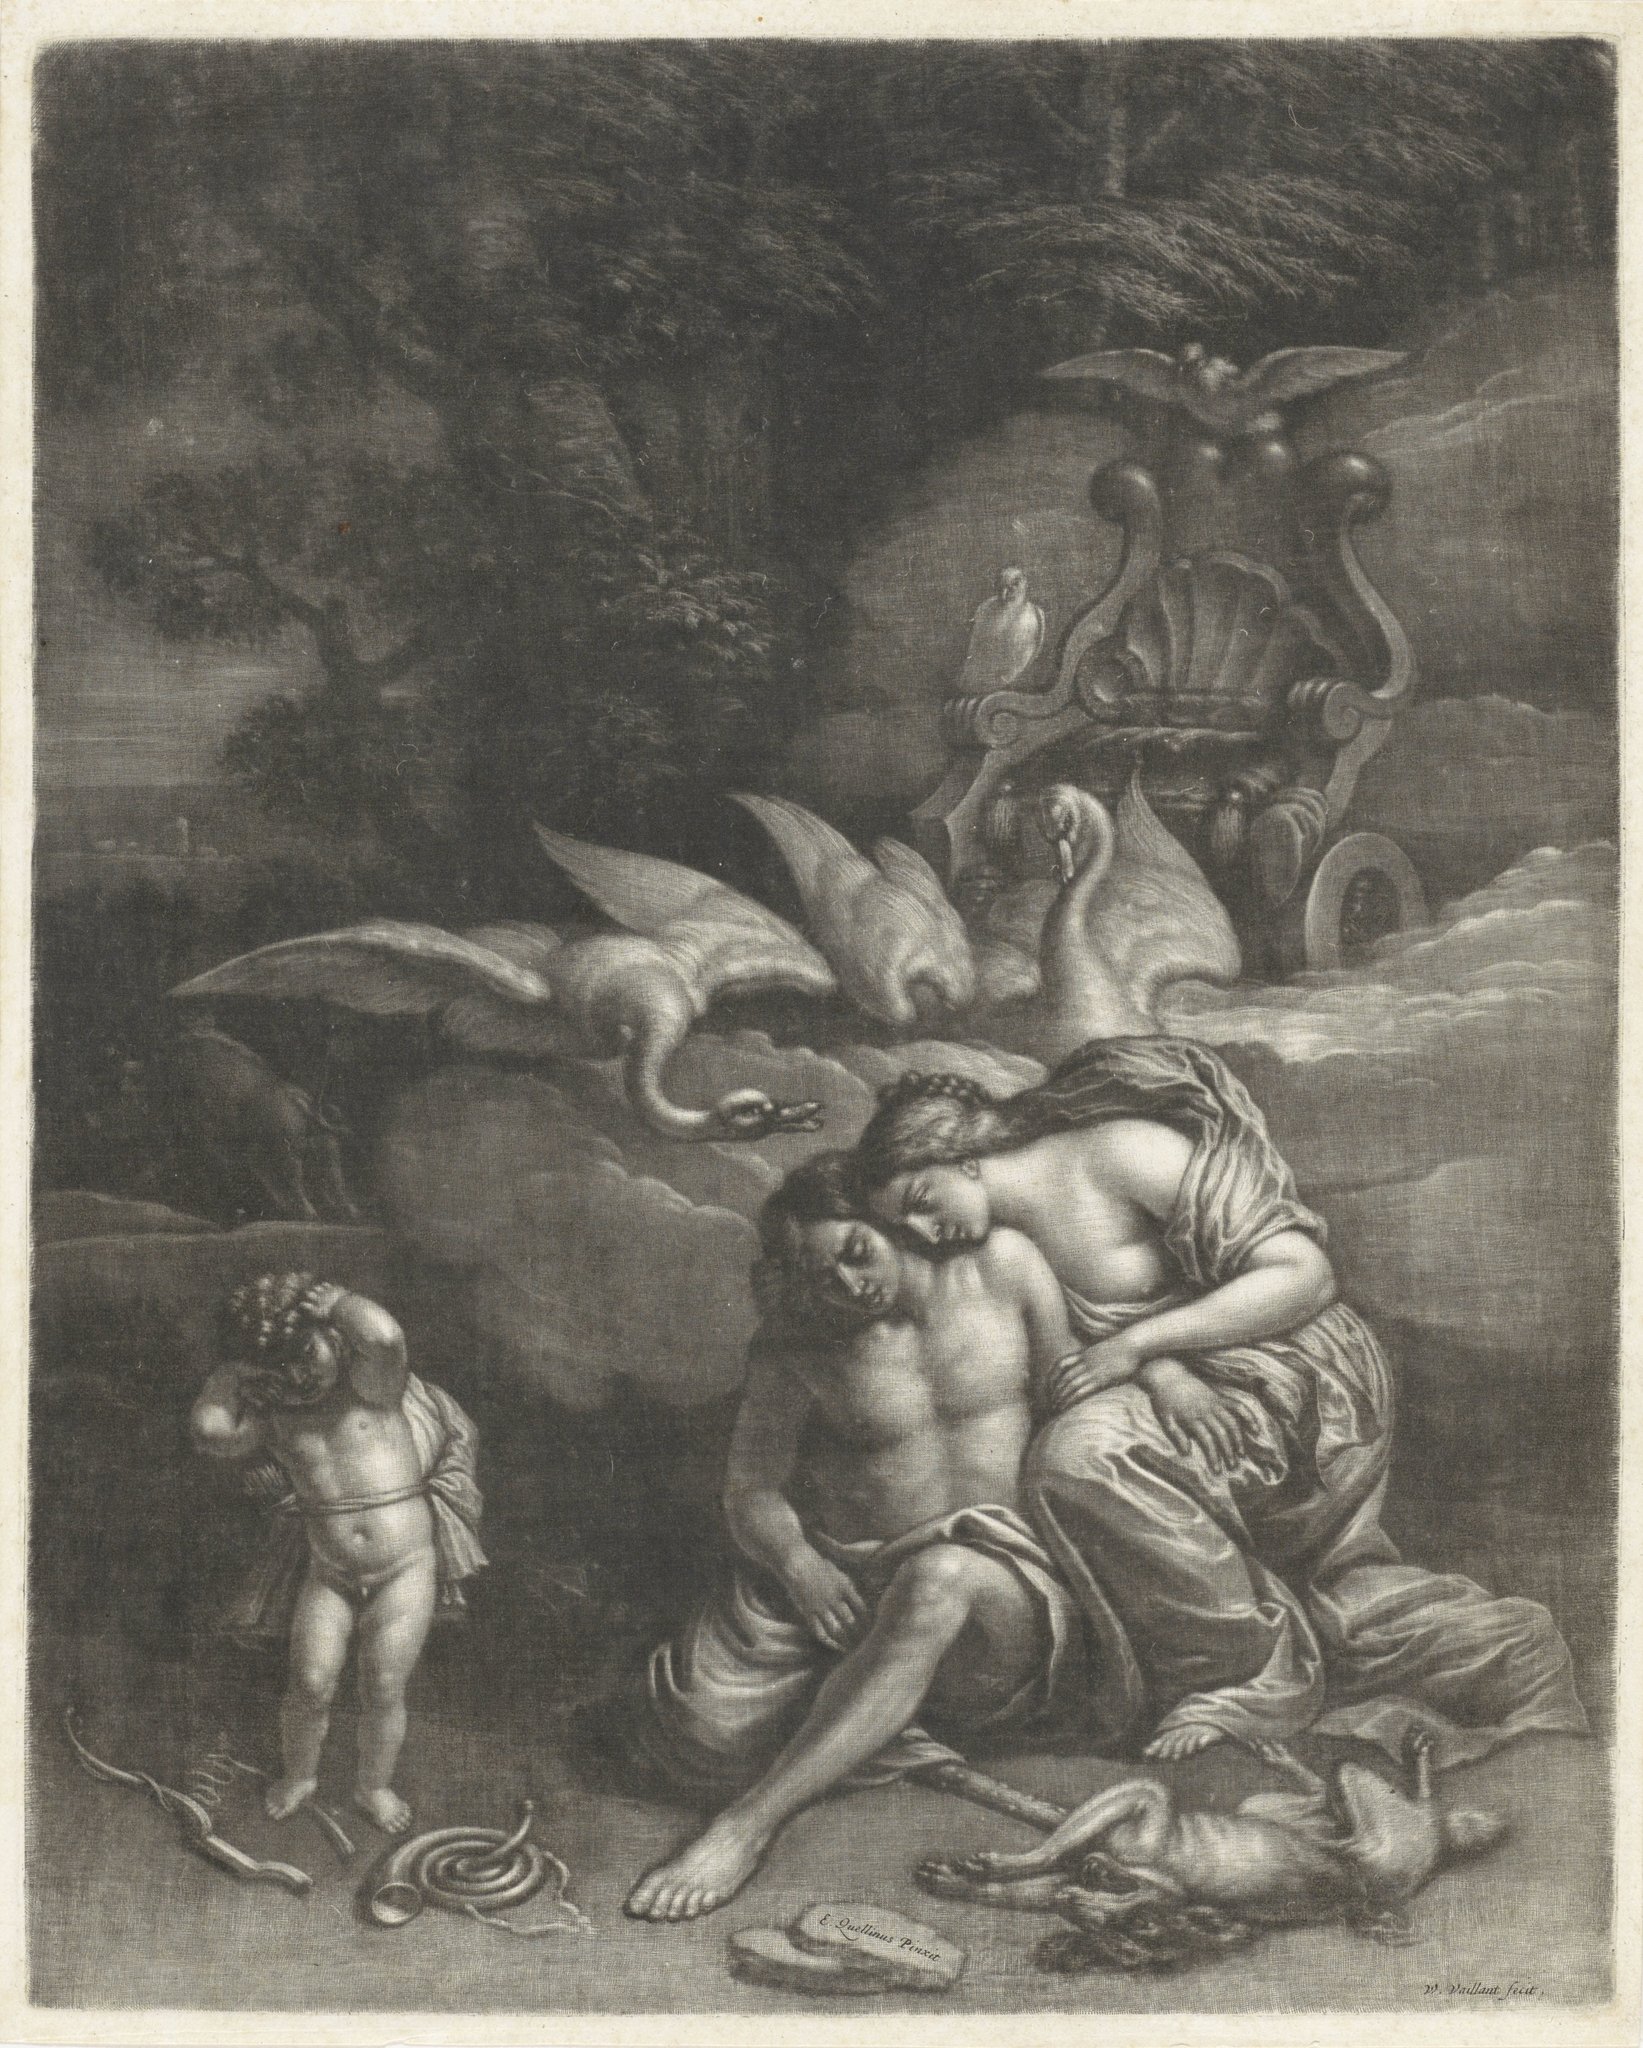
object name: print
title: Adonis sterft in de armen van Venus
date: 1658-1677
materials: paper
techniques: mezzotint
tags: venus mourning adonis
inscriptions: collector's mark: Lugt 11, collector's mark: Lugt 10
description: Adonis sterft in de armen van Venus. Venus en Amor treuren om zijn dood. Tijdens de jacht raakte Adonis zwaar gewond in een gevecht met een wild zwijn. Op de achtergrond de wagen van Venus en het wilde zwijn.